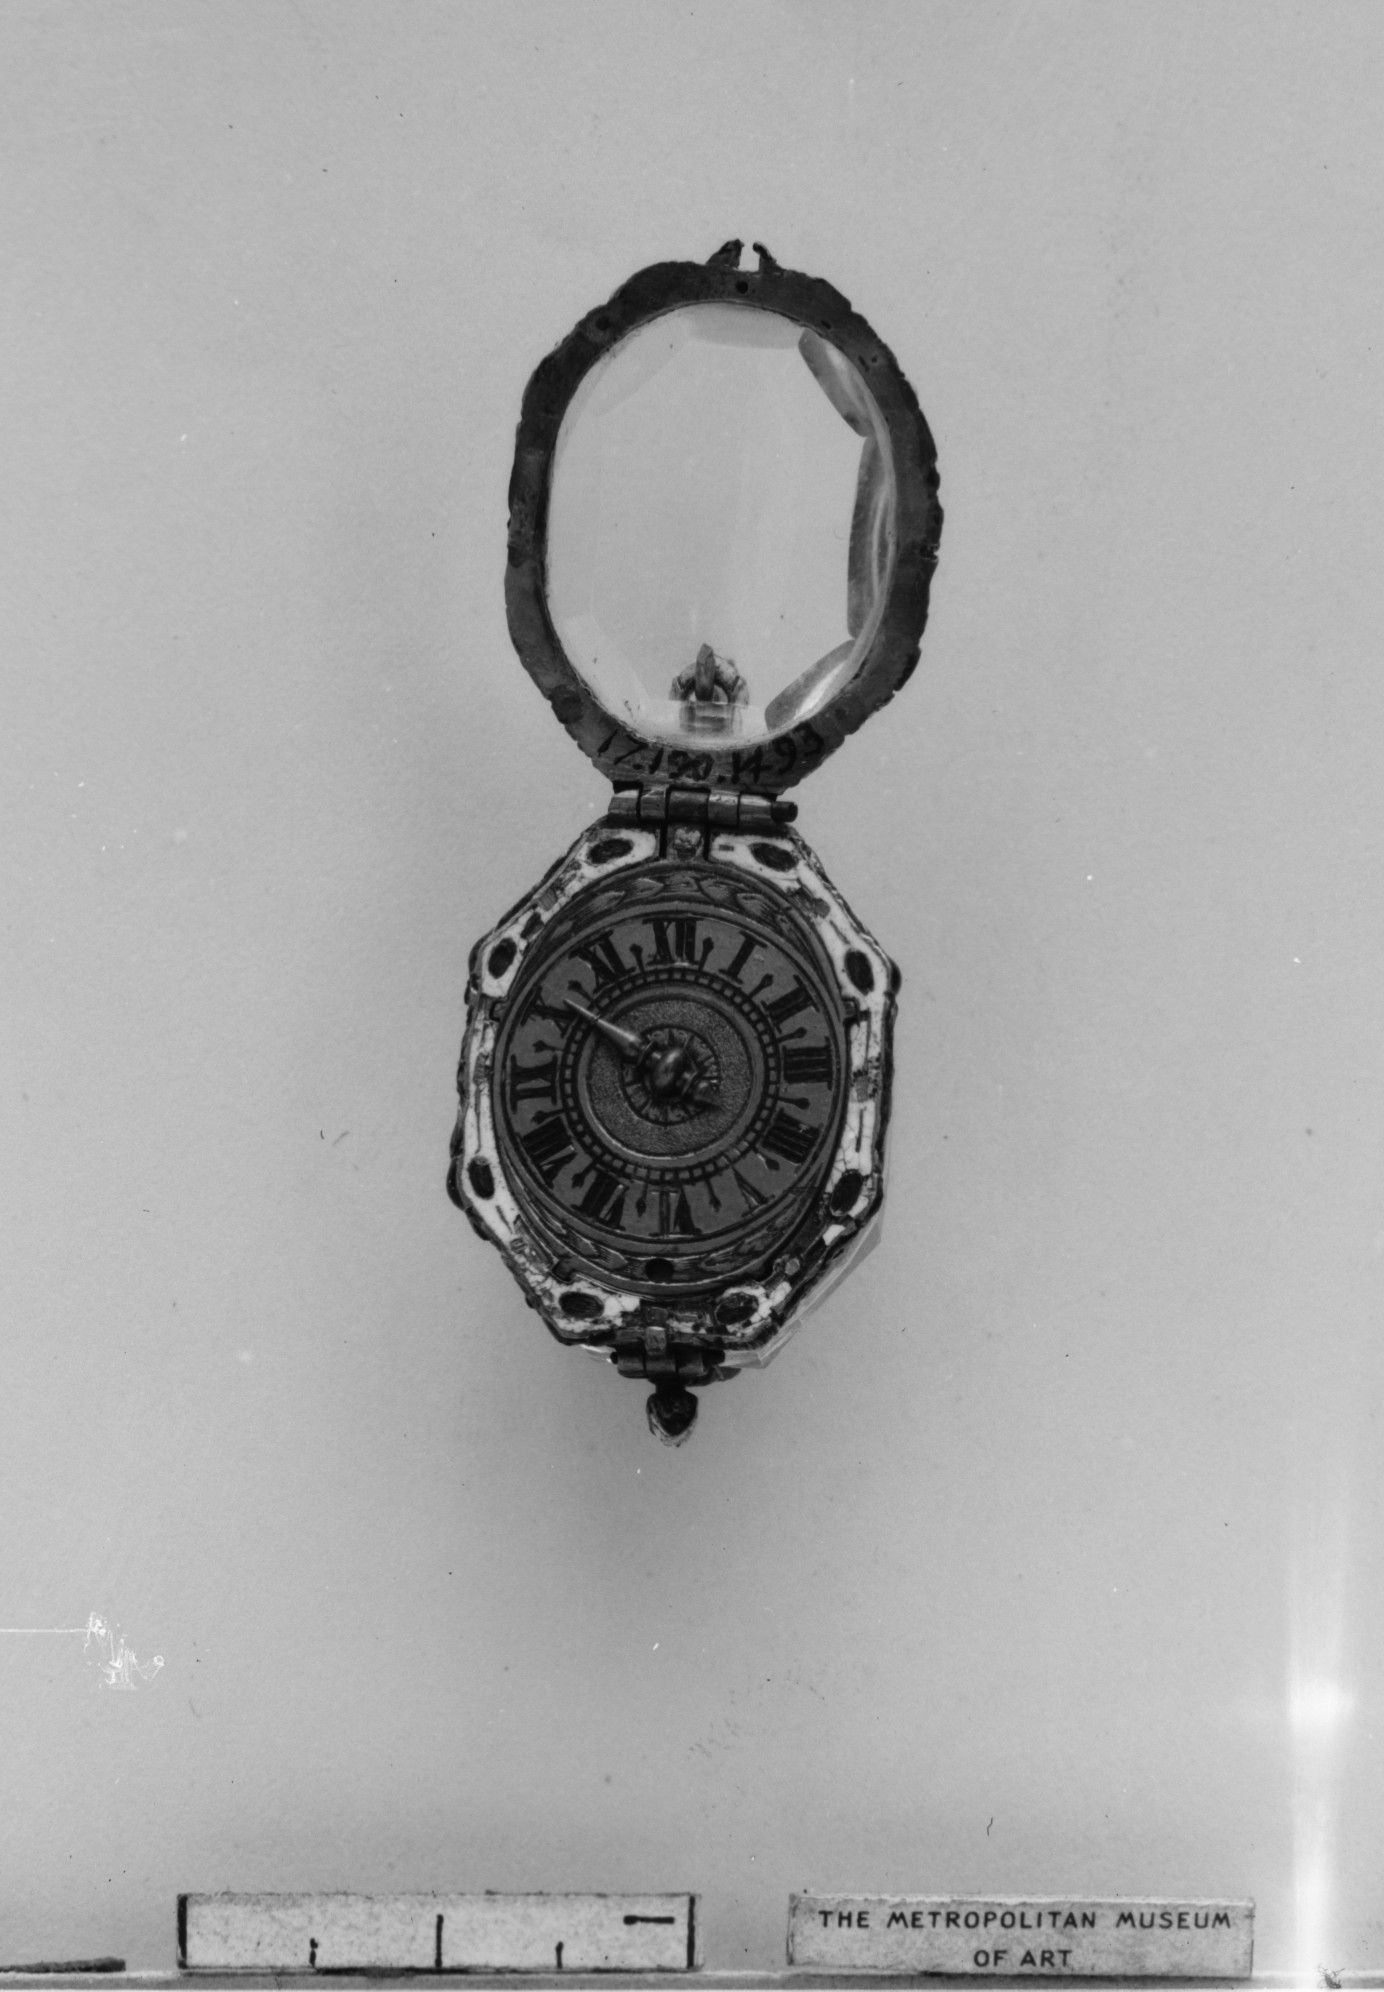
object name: watch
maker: john stiles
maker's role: maker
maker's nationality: british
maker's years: 1697-1727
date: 1680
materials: enamel, gold, quartz